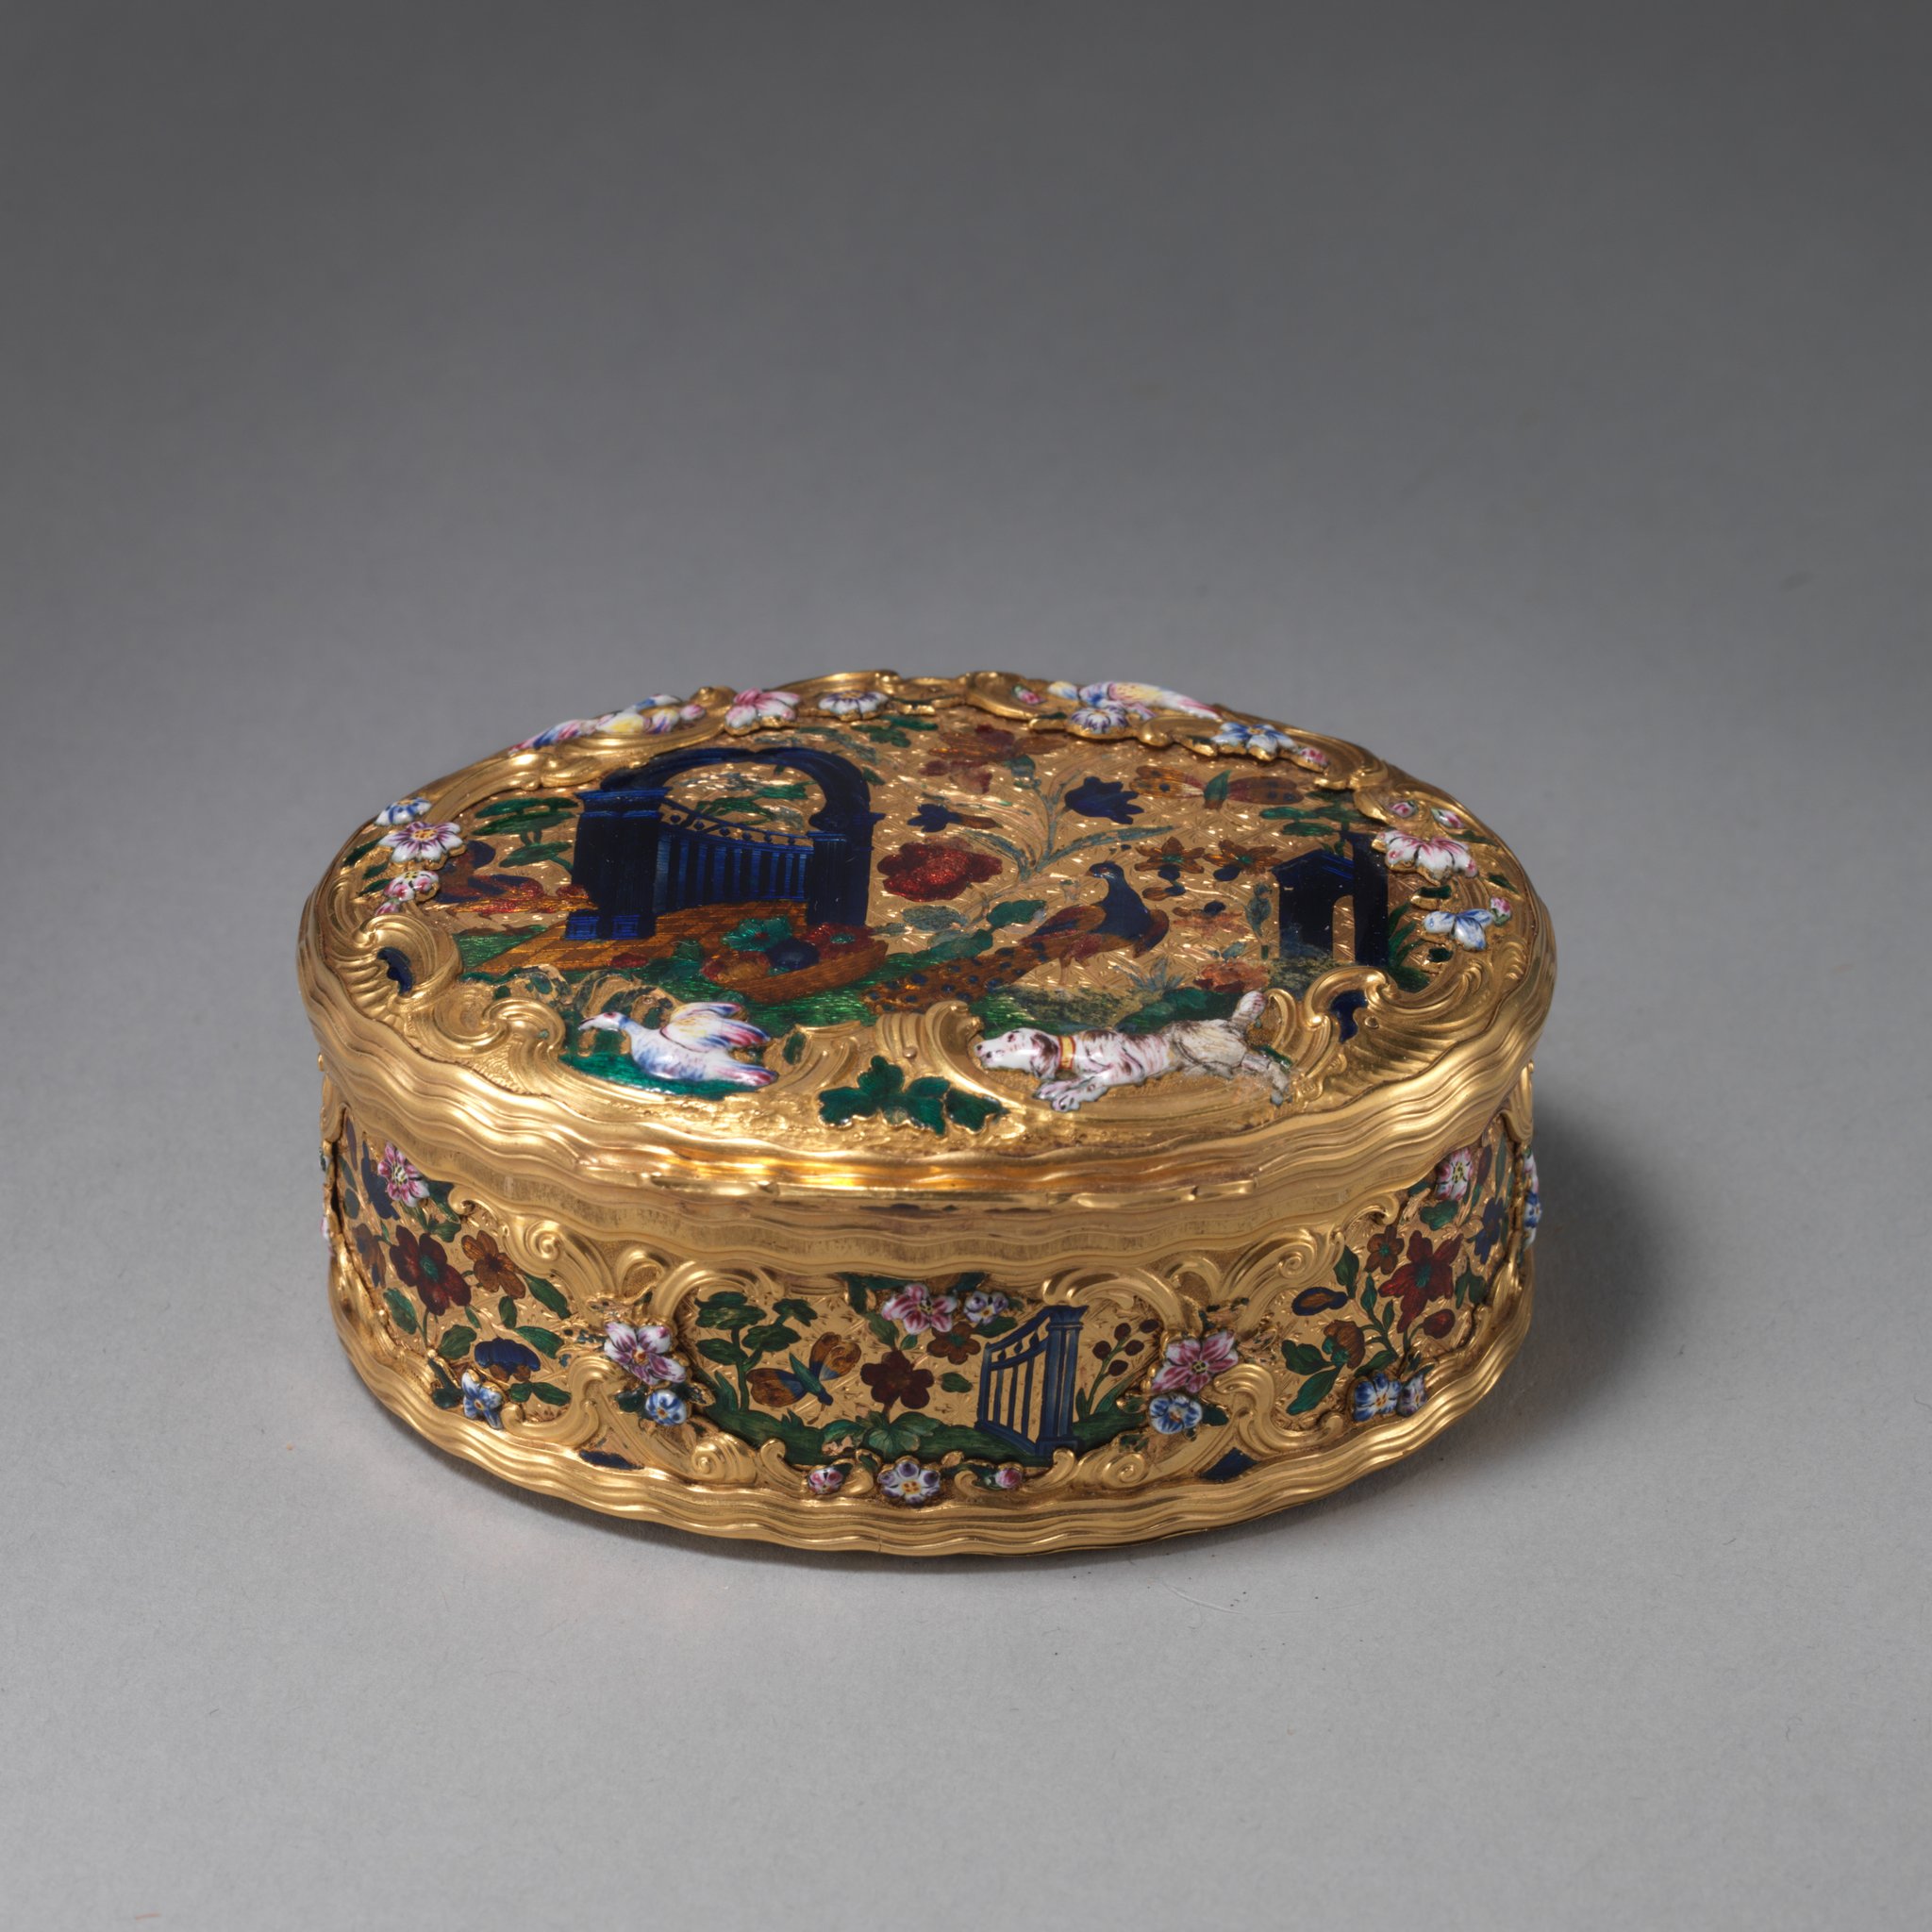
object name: snuffbox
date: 1750-1760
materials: enamel, gold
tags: birds,peacocks,dogs,insects,flowers